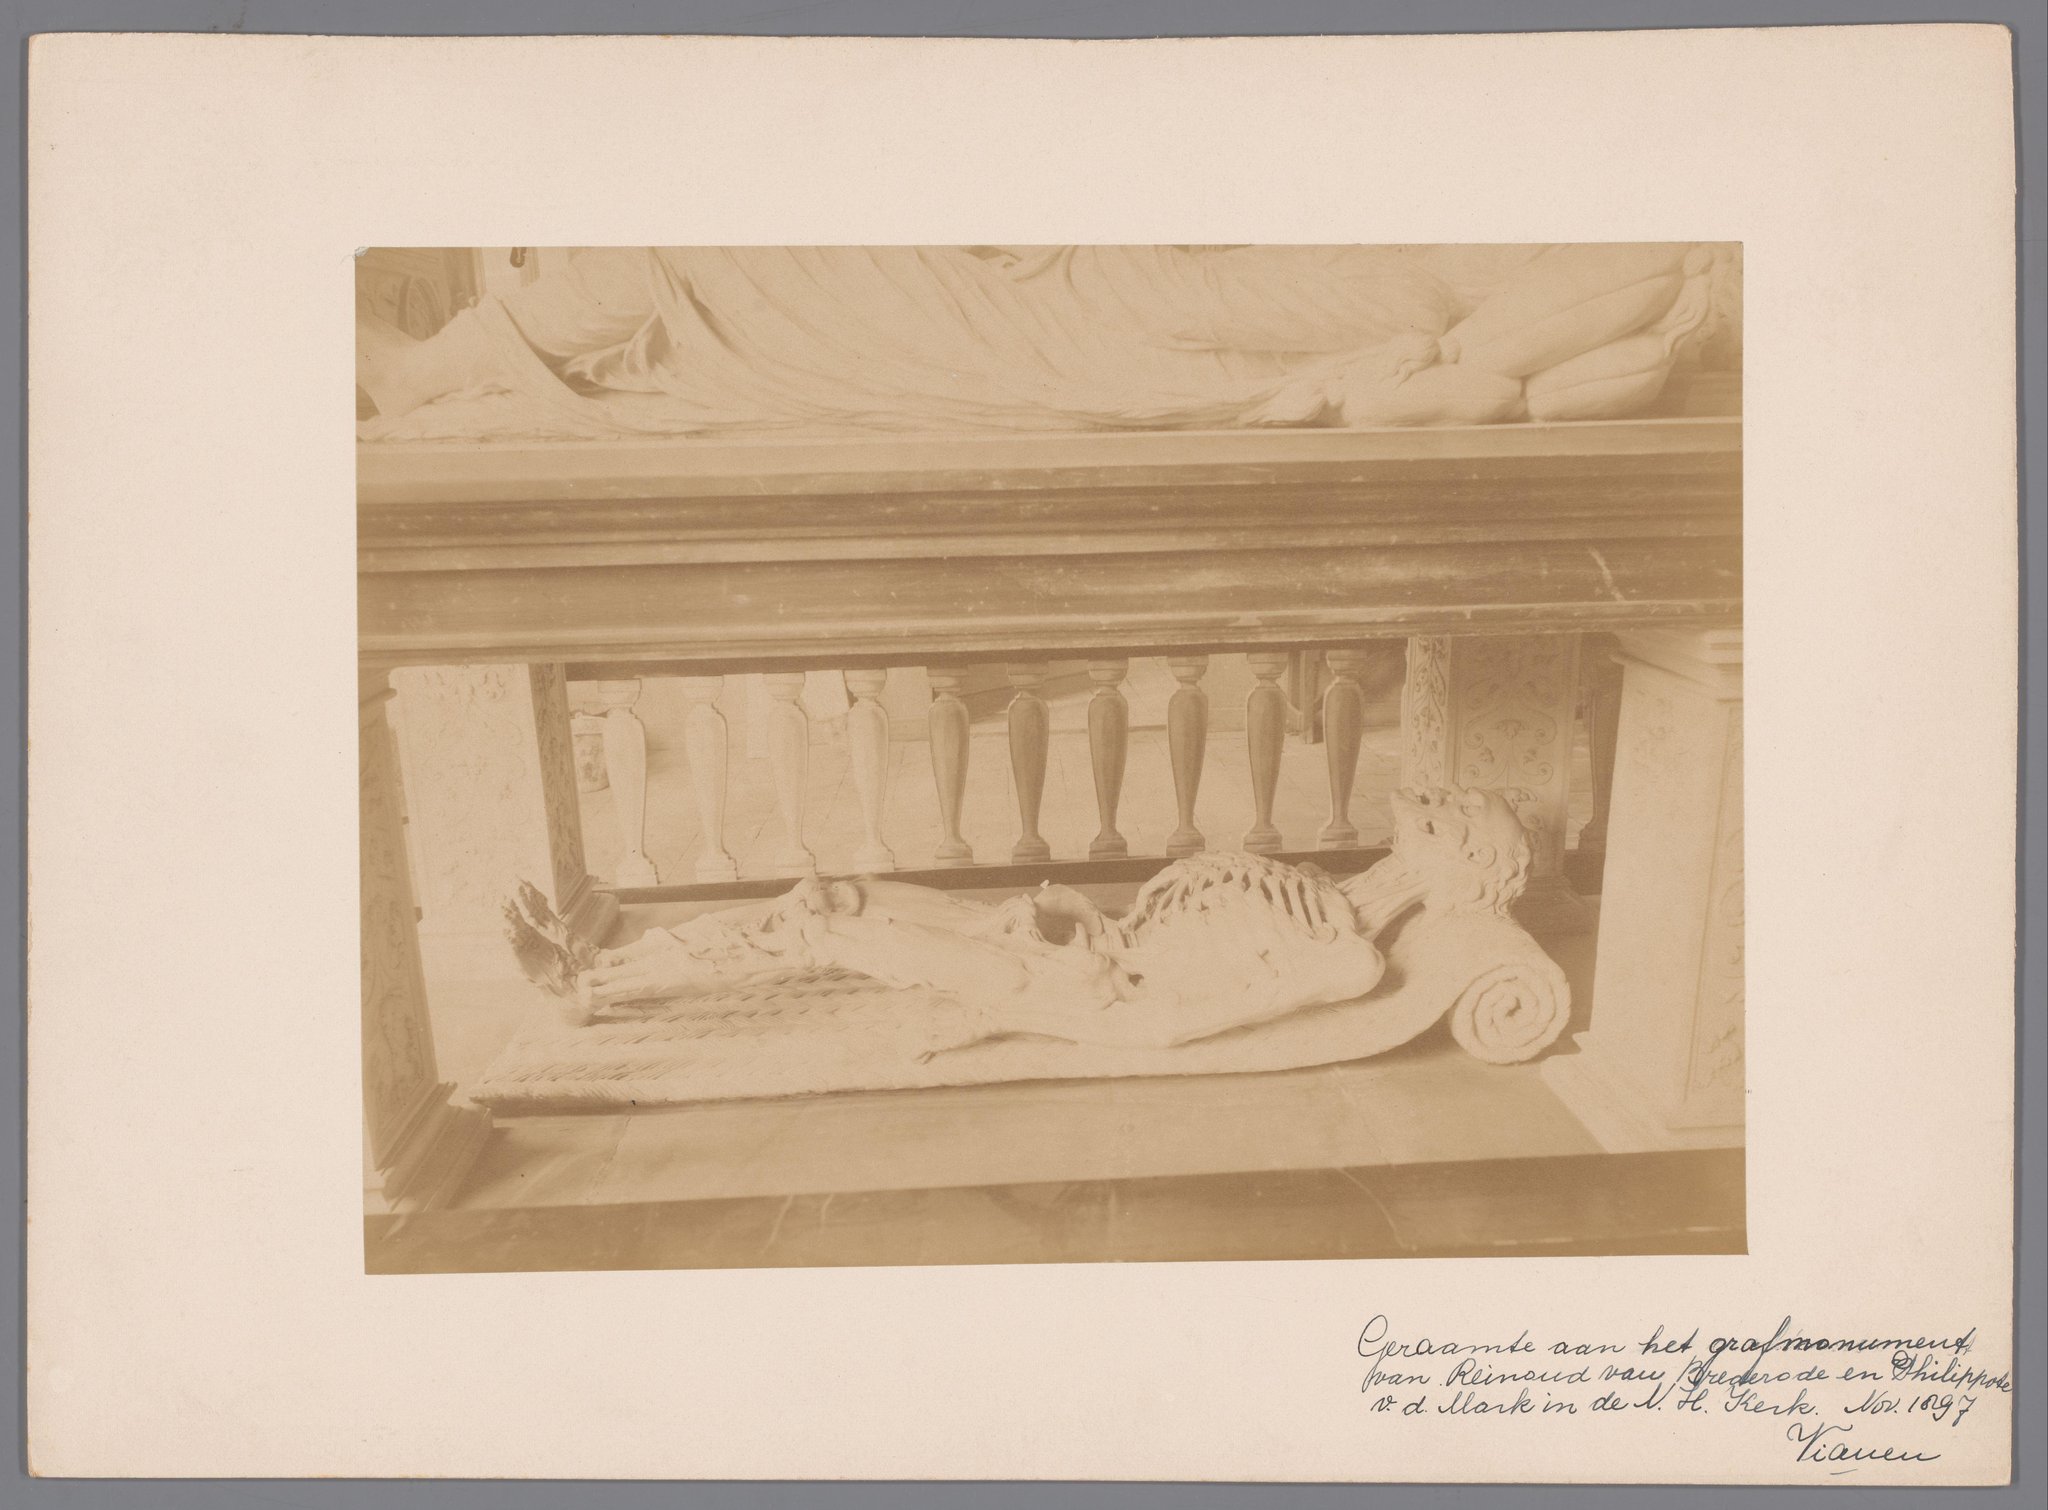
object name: photograph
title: Grafmonument van Reinoud van Brederode in de Grote Kerk te Vianen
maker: anoniem (monumentenzorg)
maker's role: fotograaf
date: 1897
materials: cardboard, photographic support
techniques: albumen print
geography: grote kerk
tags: grave-building, monumental tomb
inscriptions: annotation: ‘Photo van het geraamte aan het grafmonment van der graaf van Brederode in de N.H. Kerk te Vianen (Z.H.)/ Nov. 1897’, annotation: ‘Geraamte aan het grafmonument van Reinoud van Brederode en Philippote van der Mark in de N.H. Kerk Nov. 1897/ Vianen’